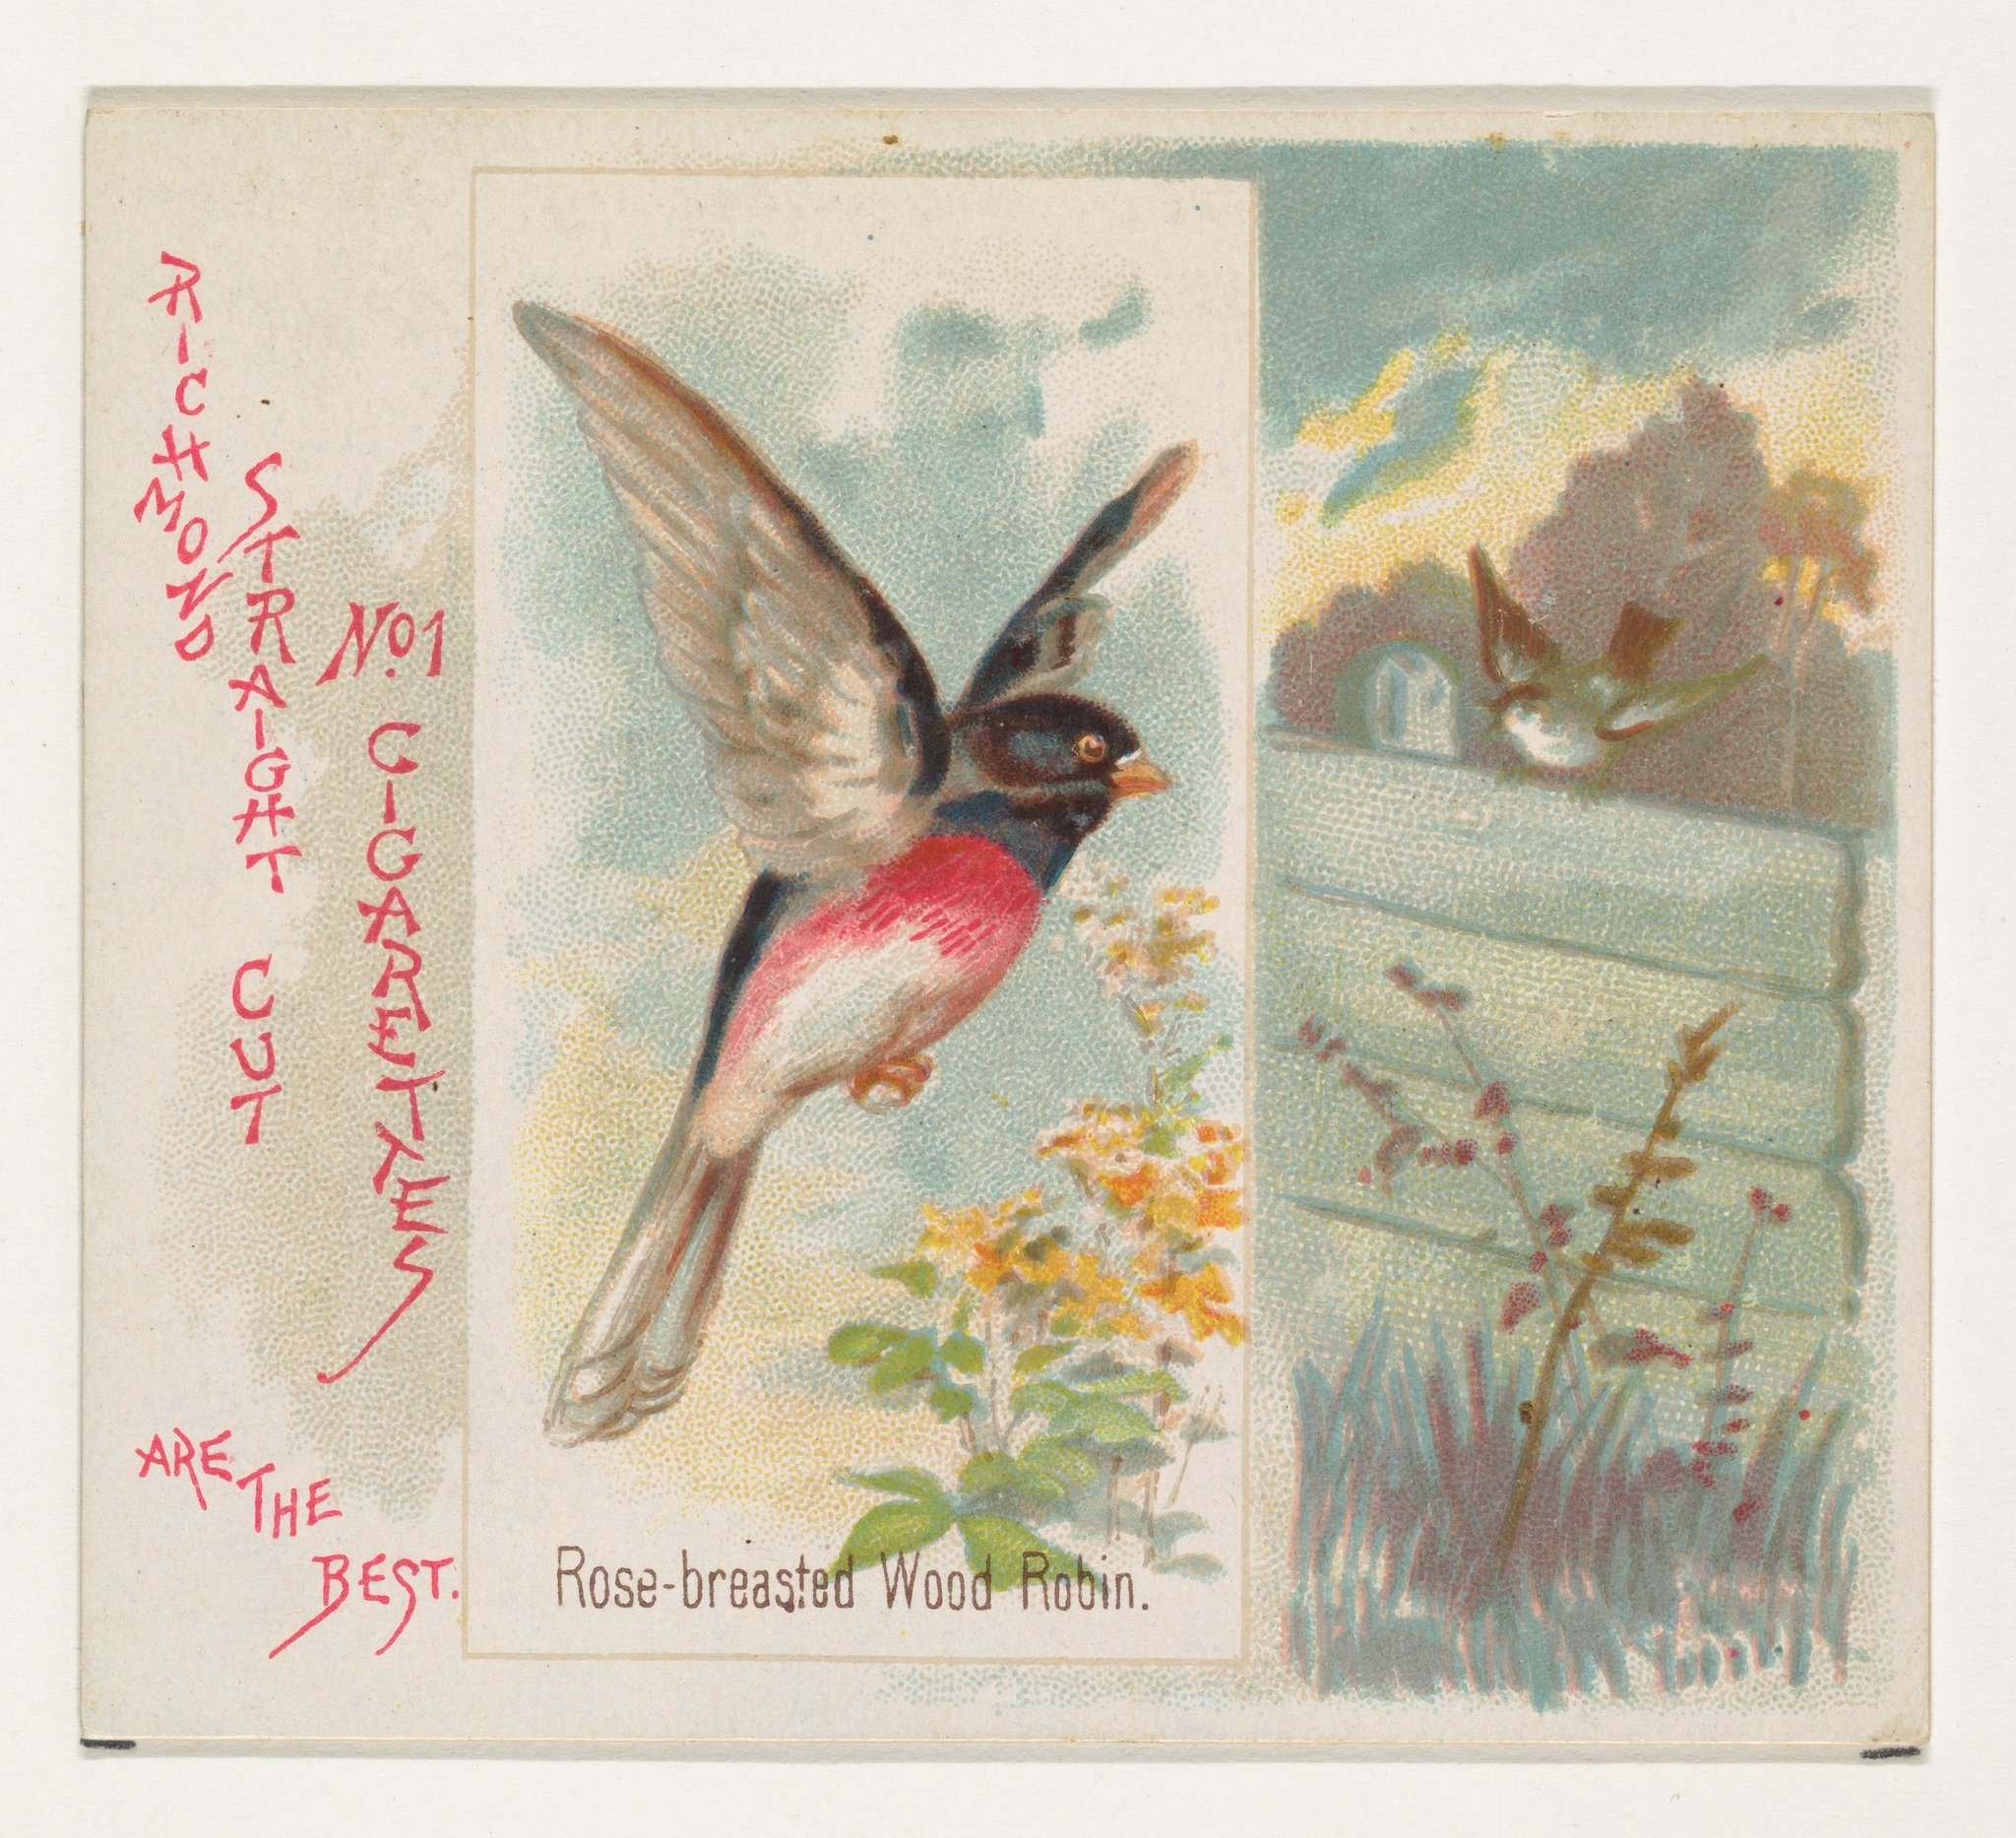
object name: print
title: Rose-breasted Wood Robin, from the Song Birds of the World series (N42) for Allen & Ginter Cigarettes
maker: allen & ginter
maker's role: publisher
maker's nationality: american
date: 1890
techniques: color lithograph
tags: birds